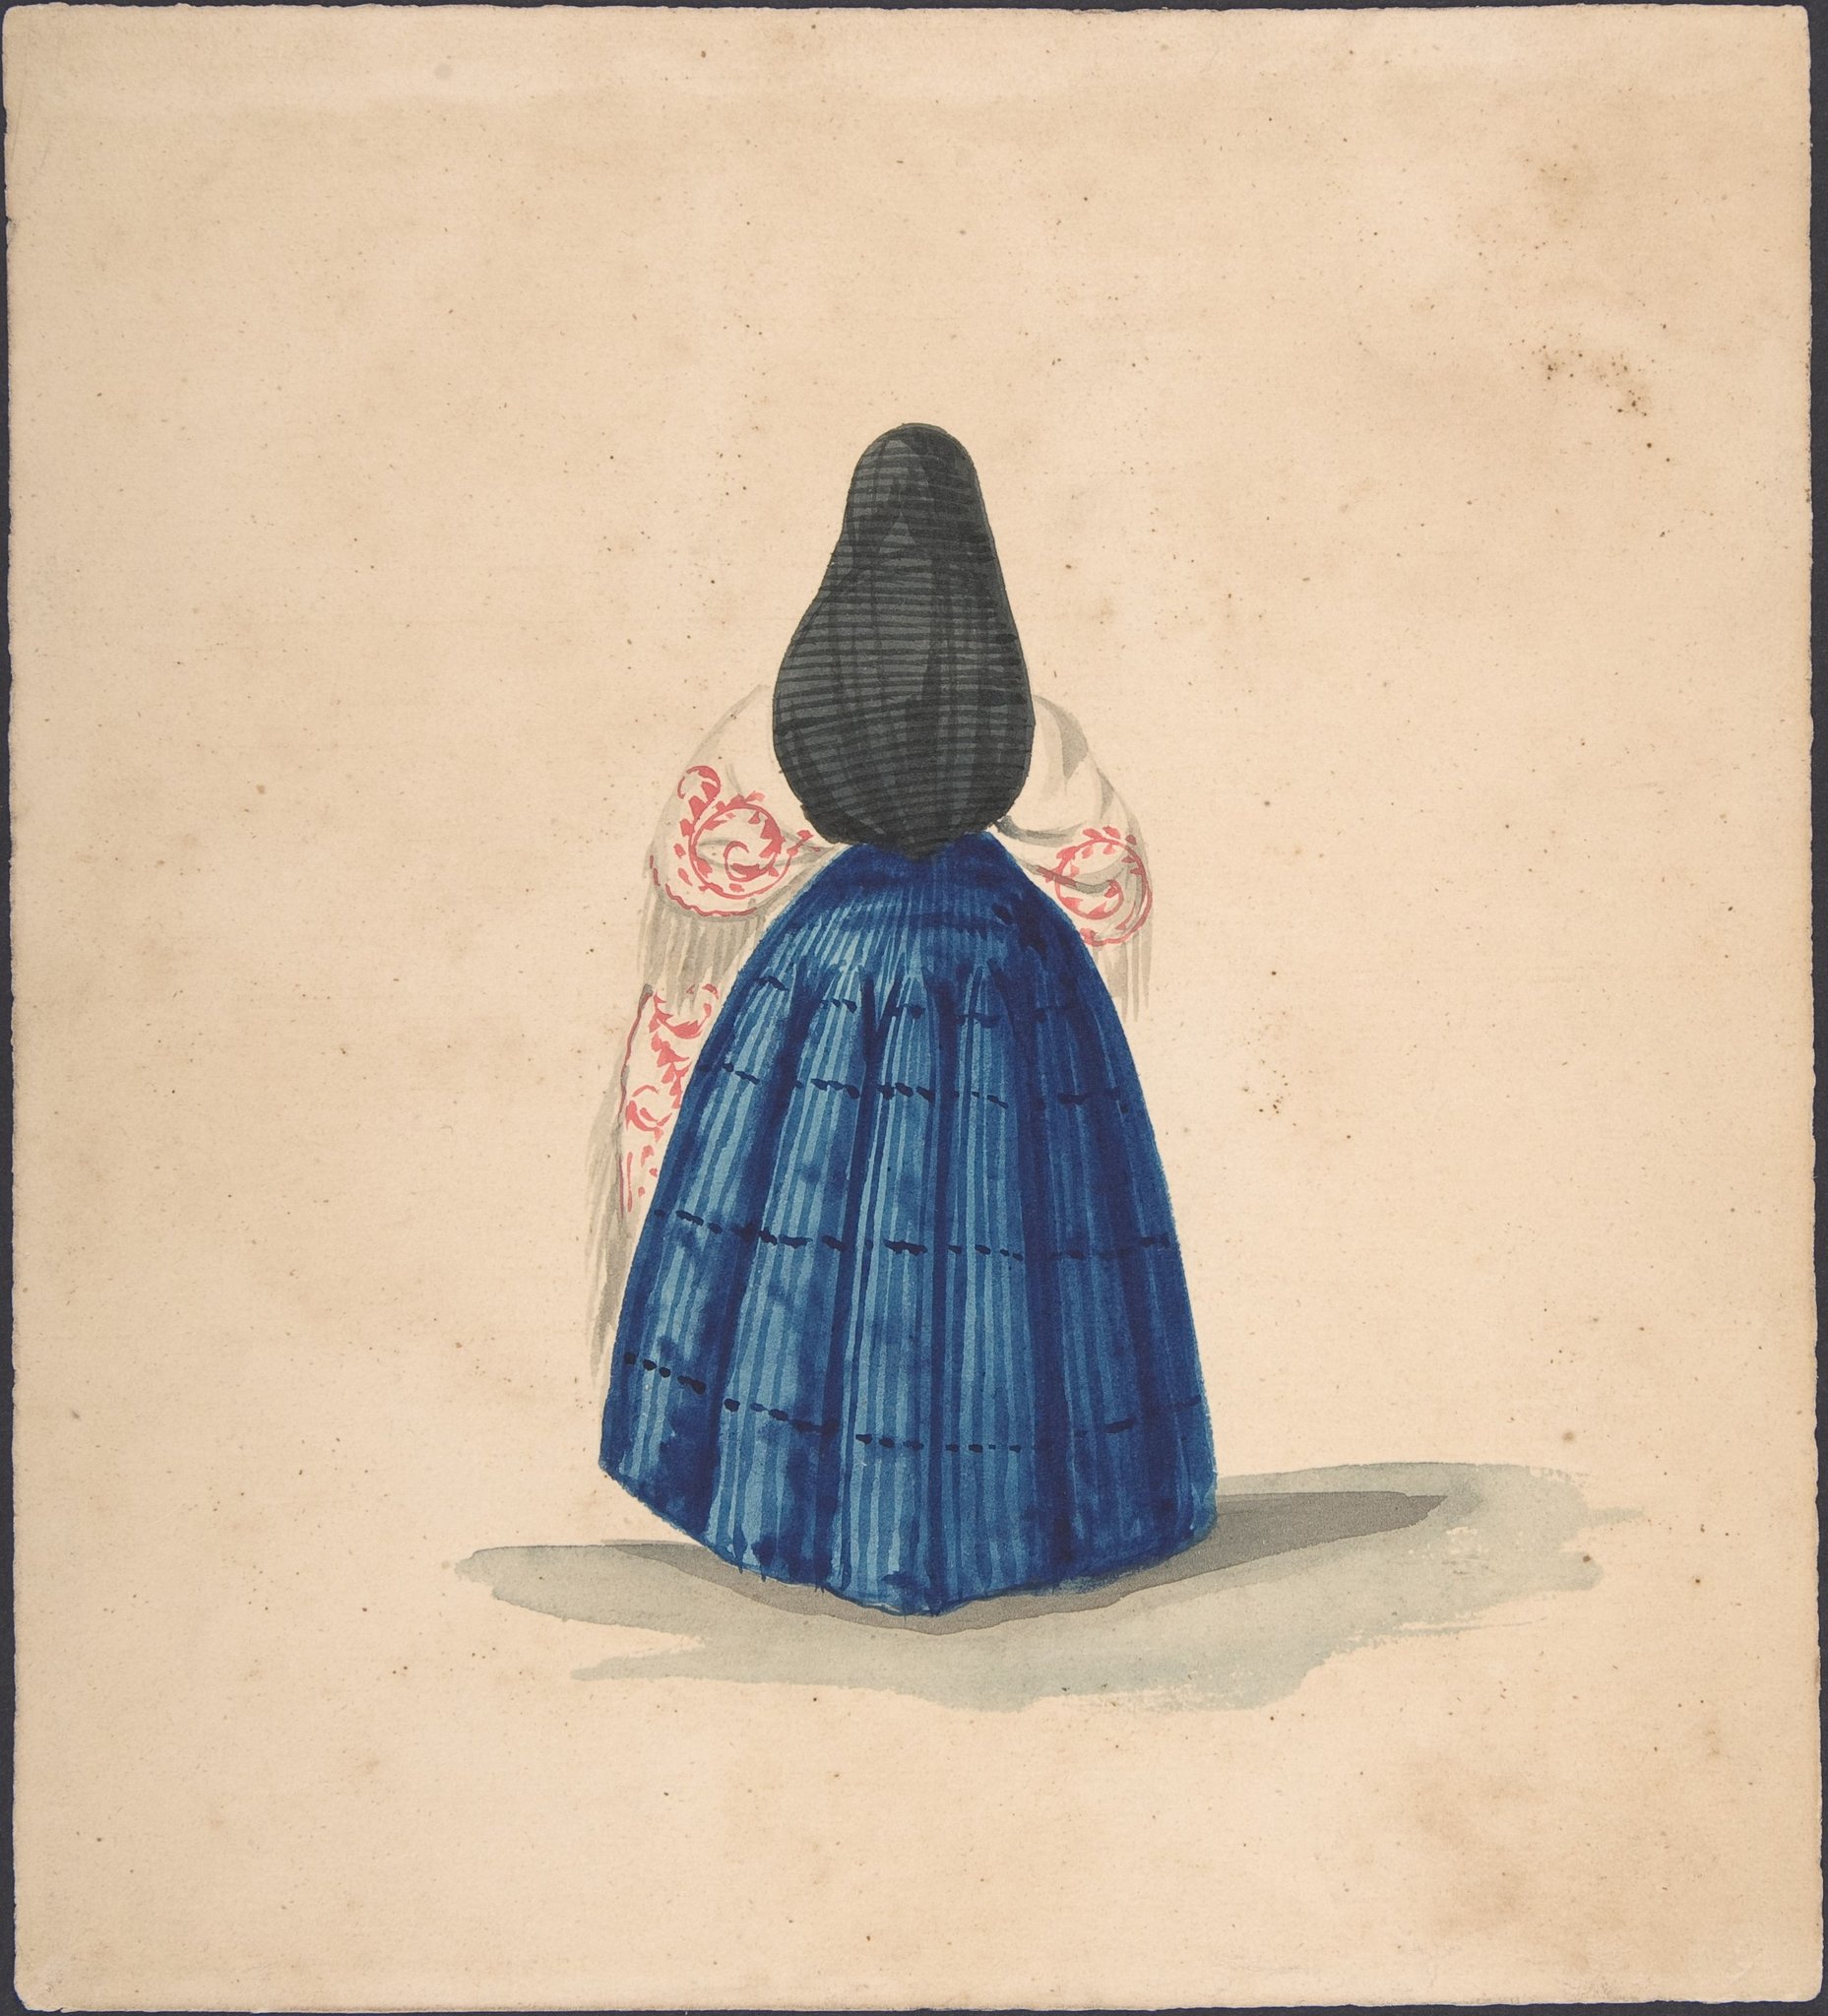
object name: drawing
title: A Standing Woman Seen from the Back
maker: anonymous, peruvian, 19th century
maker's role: artist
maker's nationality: peruvian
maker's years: 1800-1900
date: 1840-1850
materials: ink, watercolor, paper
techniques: brush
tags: women